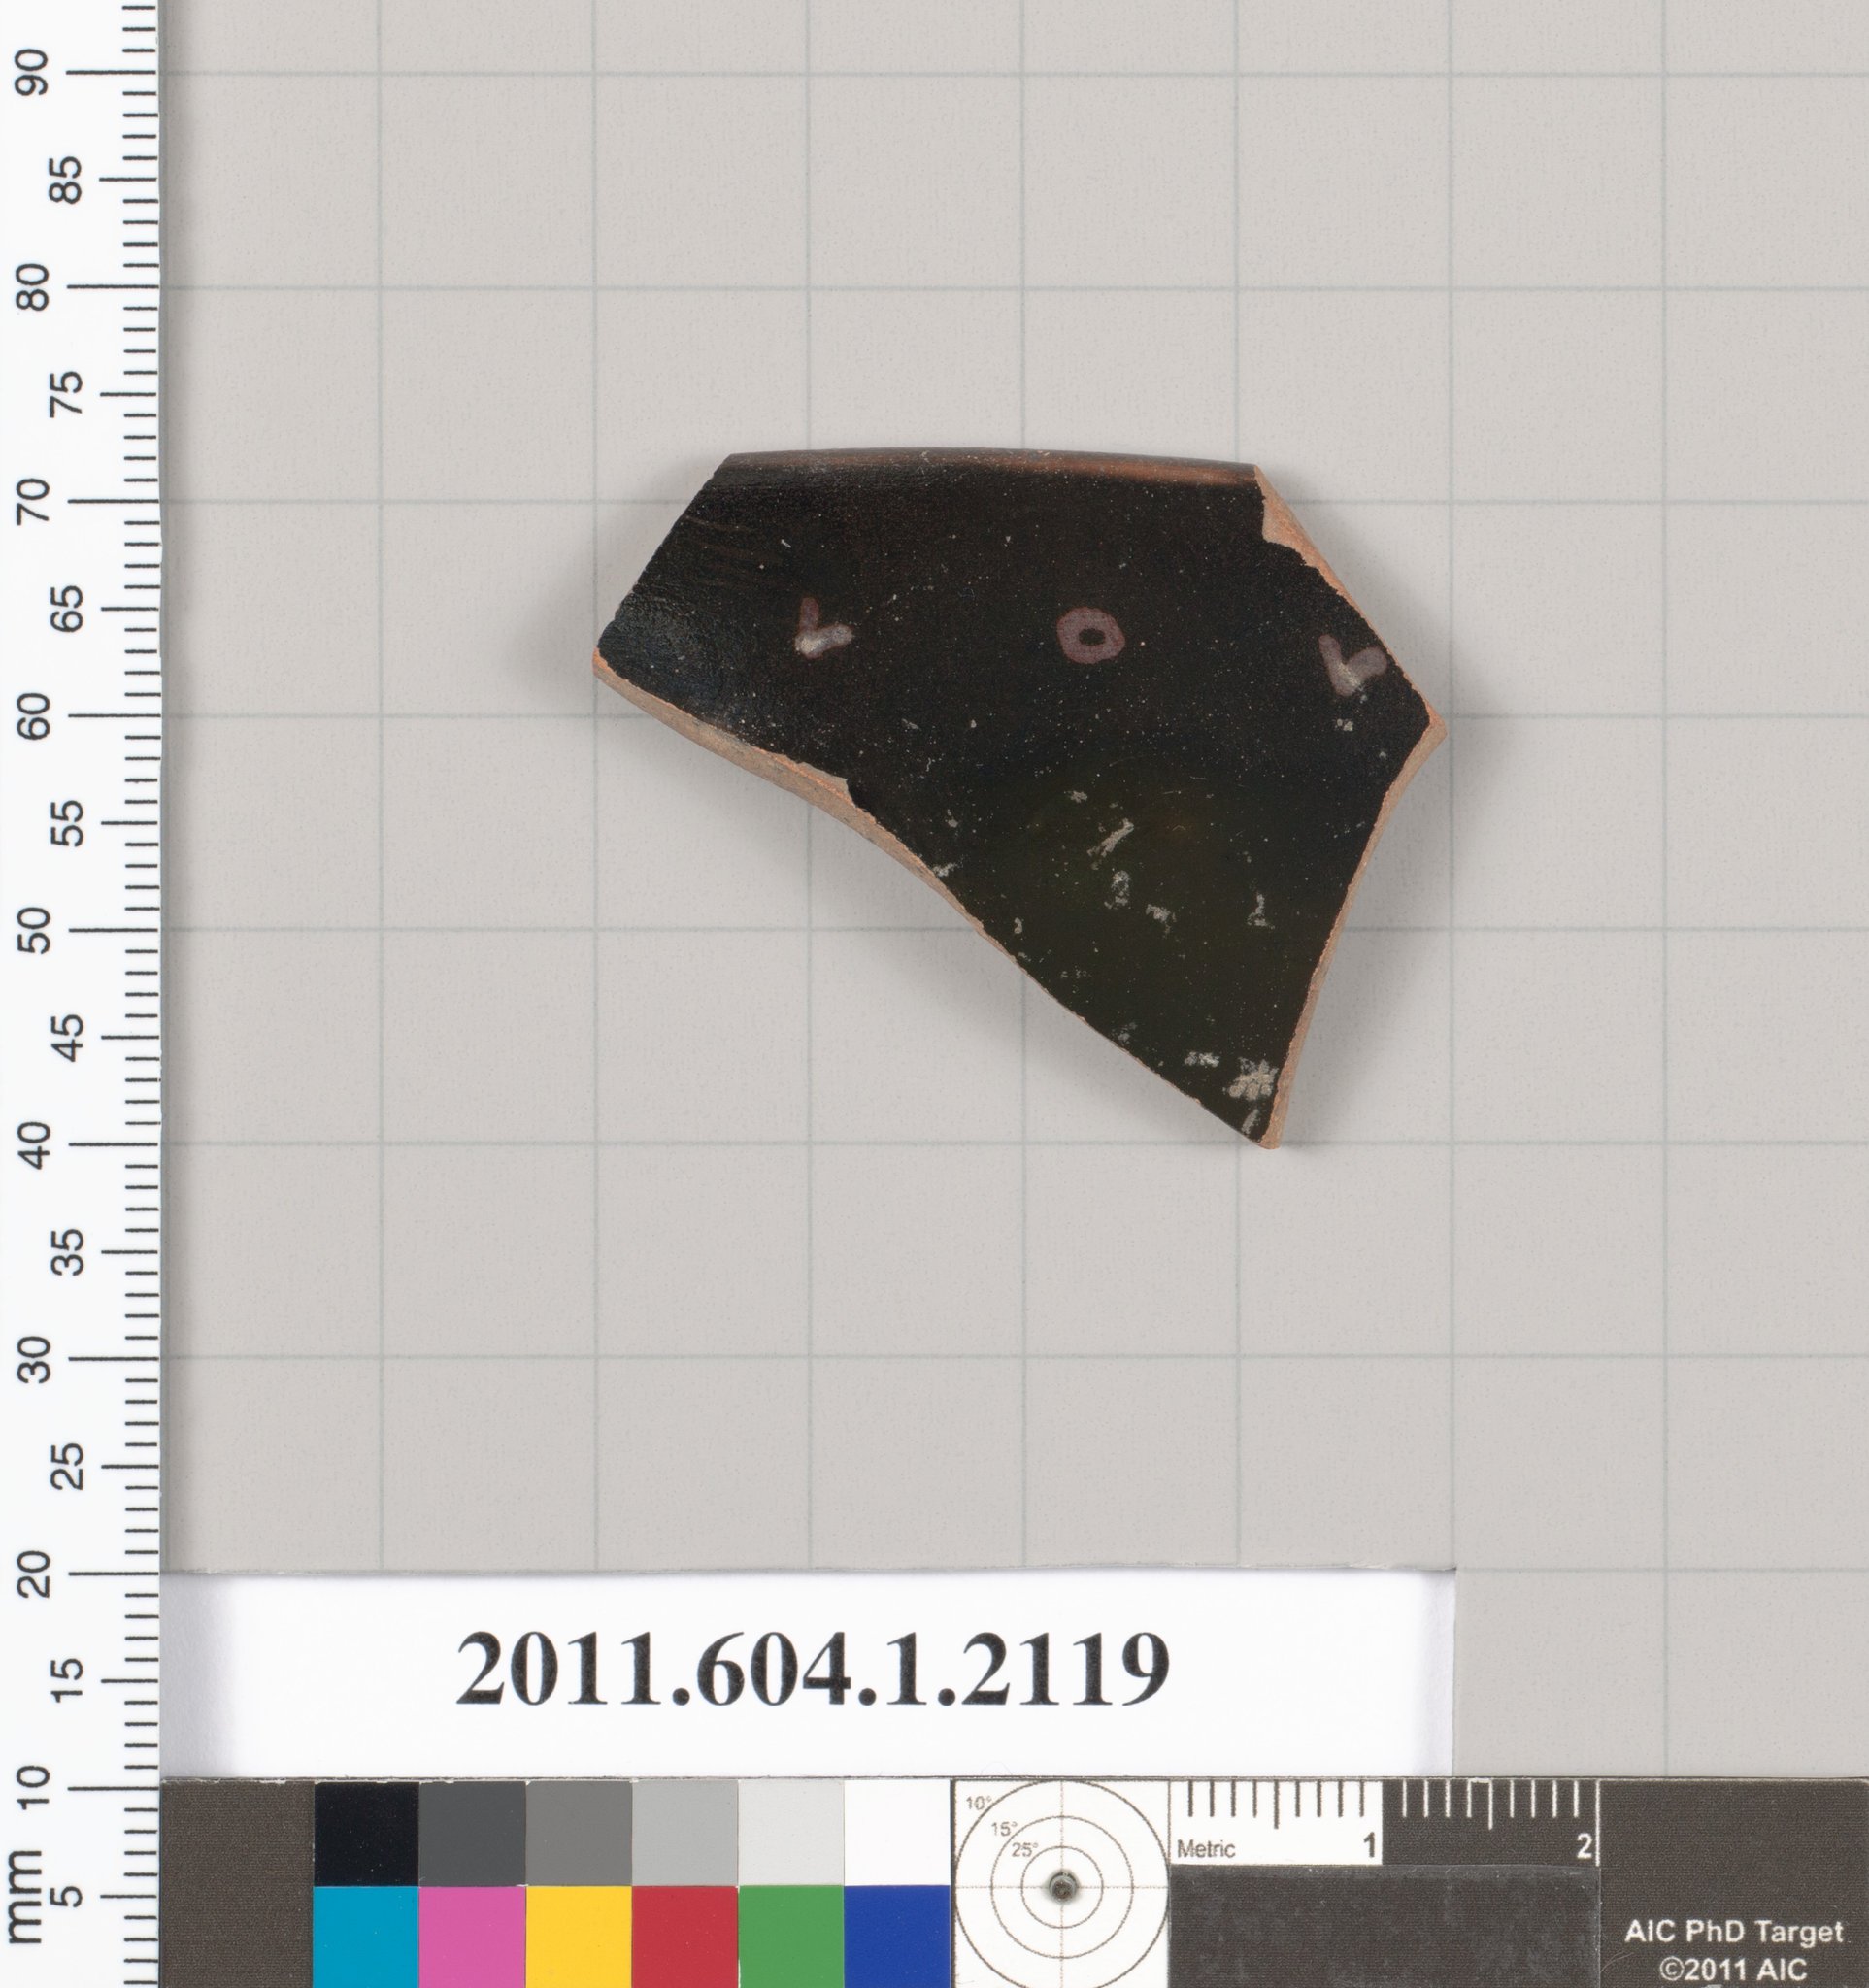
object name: kylix fragment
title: Terracotta rim fragment of a kylix (drinking cup)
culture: greek, attic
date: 500-401 BCE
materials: terracotta